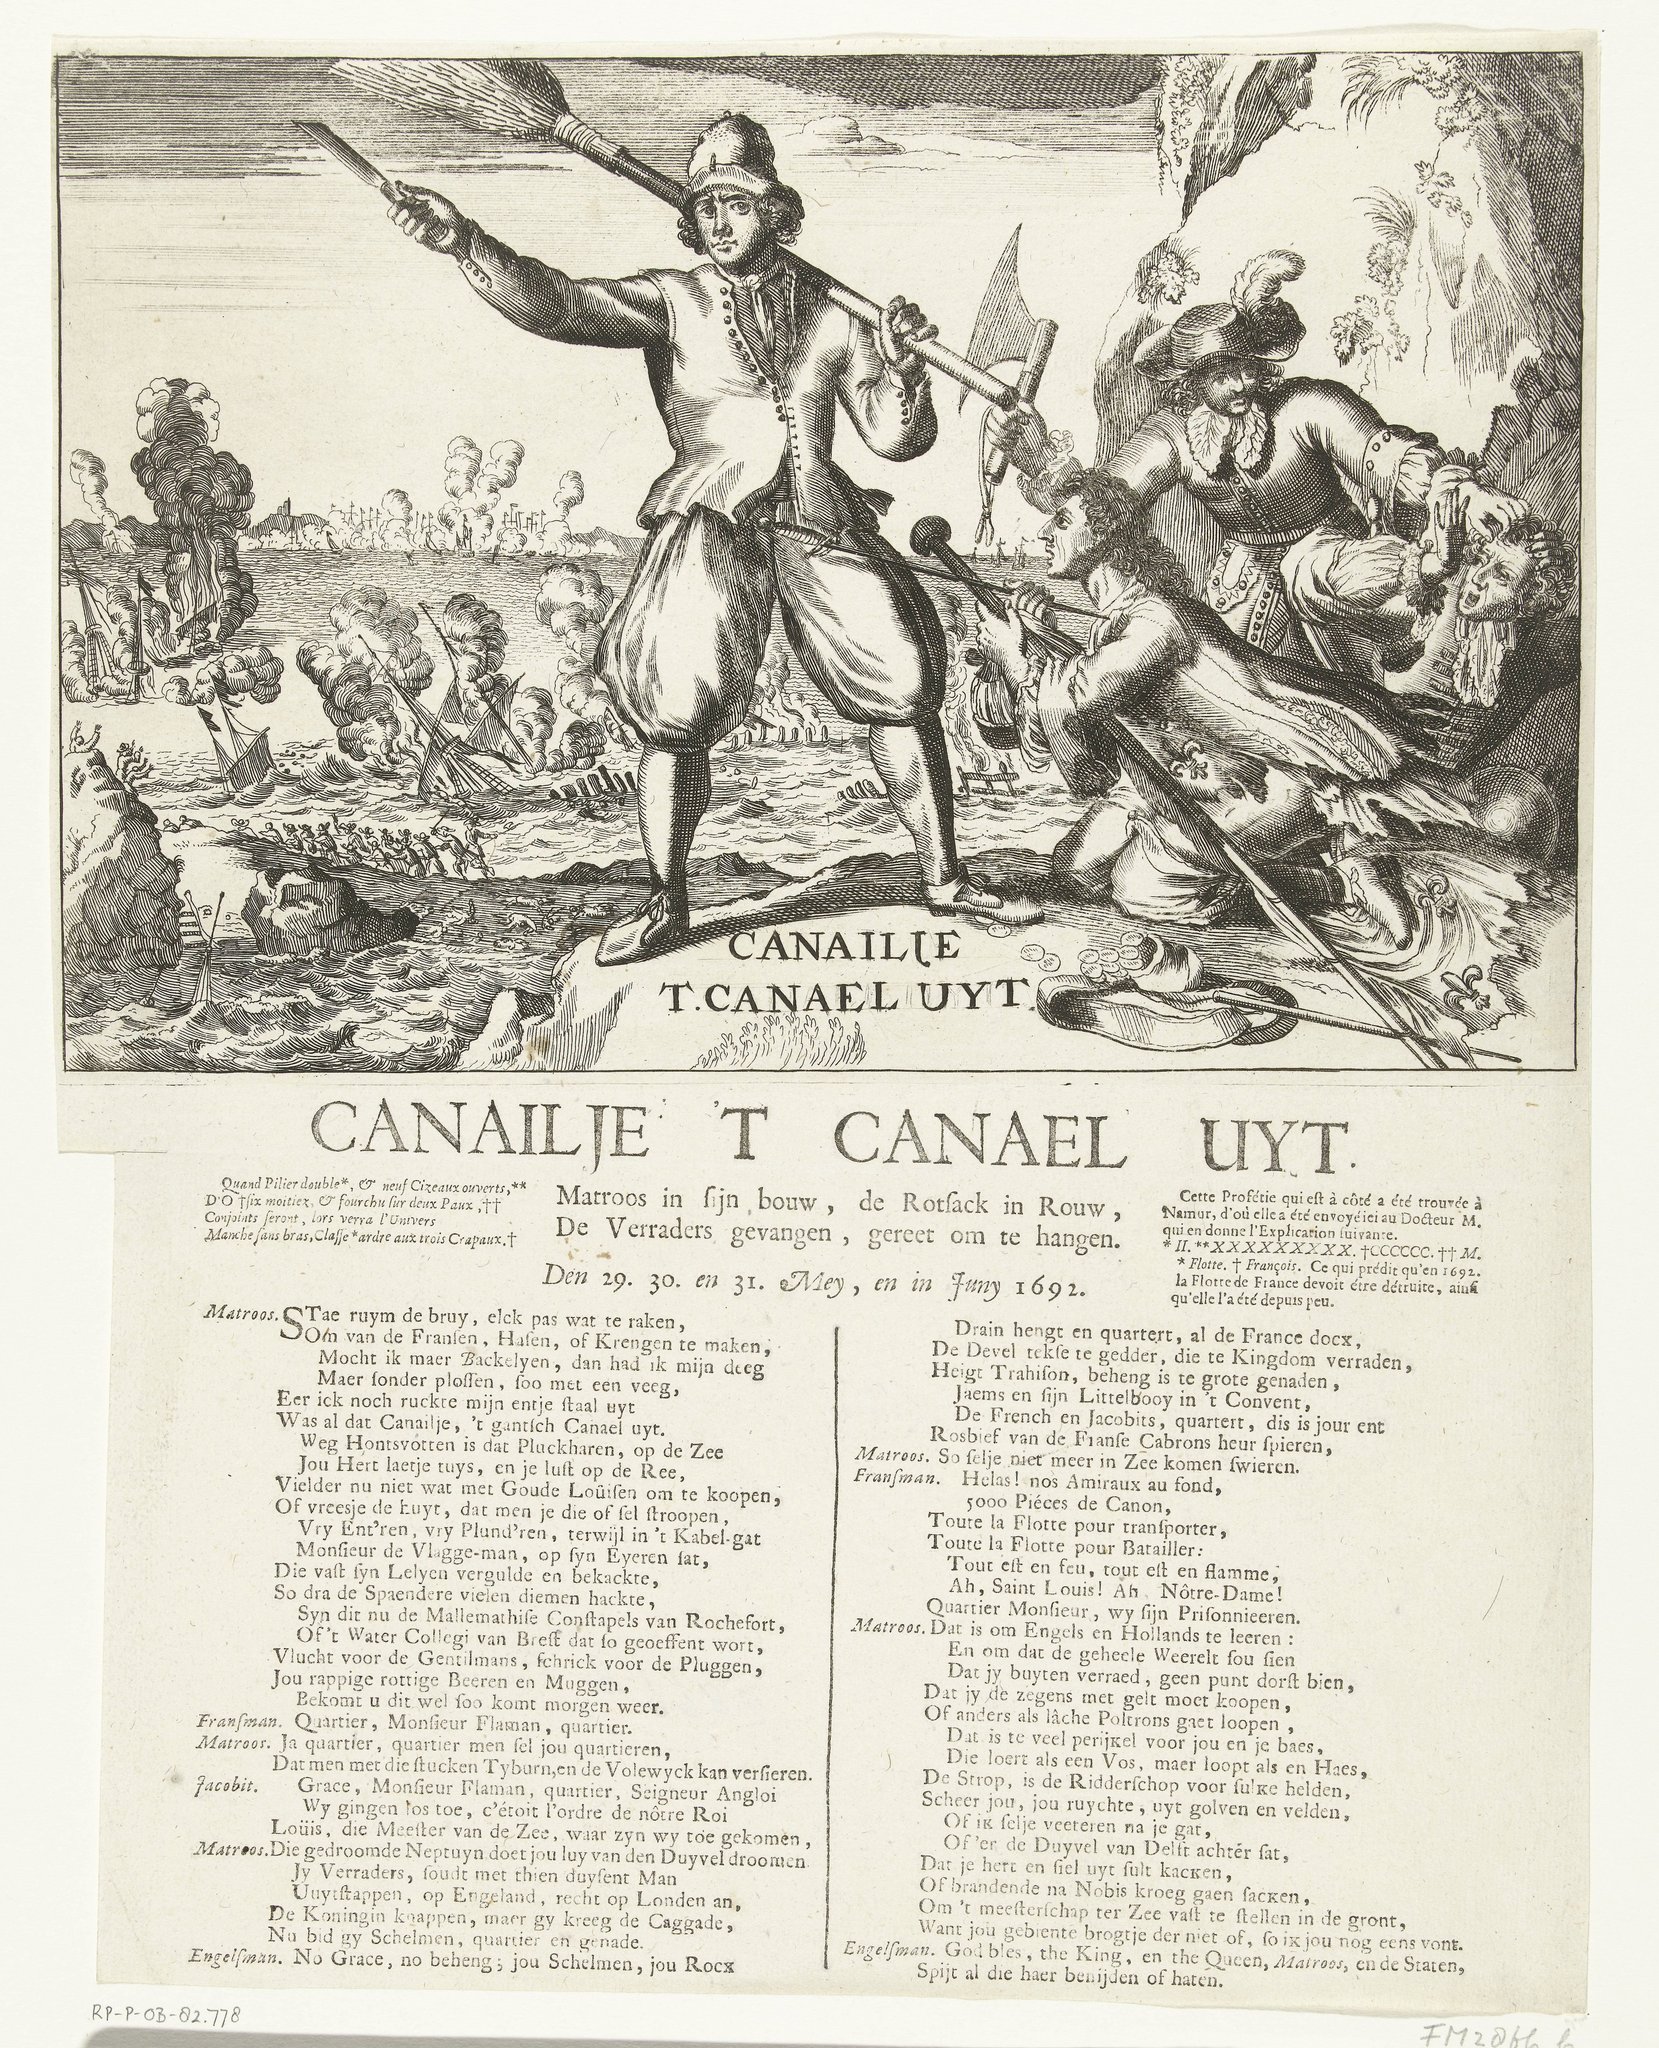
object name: print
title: Canailje t Canael uyt. Matroos in sijn bouw, de Rotsack in Rouw, De Verraders gevangen, gereet om te hangen. Den 29. 30. en 31 Mey, en Juny Anno 1692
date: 1692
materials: paper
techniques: engraving, etching, letterpress printing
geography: northern netherlands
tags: political caricatures and satires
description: Spotprent op de verbranden van de Franse schepen door de Nederlanders en Engelsen na de overwinning in de slag bij Kaap la Hogue in het Kanaal, 29 mei t/m 3 juni 1692. De Hollandse Matroos met bezem en mes, aan zijn voeten een knielende smekende Fransman. Rechts dreigt een Engelsman een Jacobiet met een hakbijl. Met onderschrift in twee kolommen en enkele toelichtingen in het Frans.